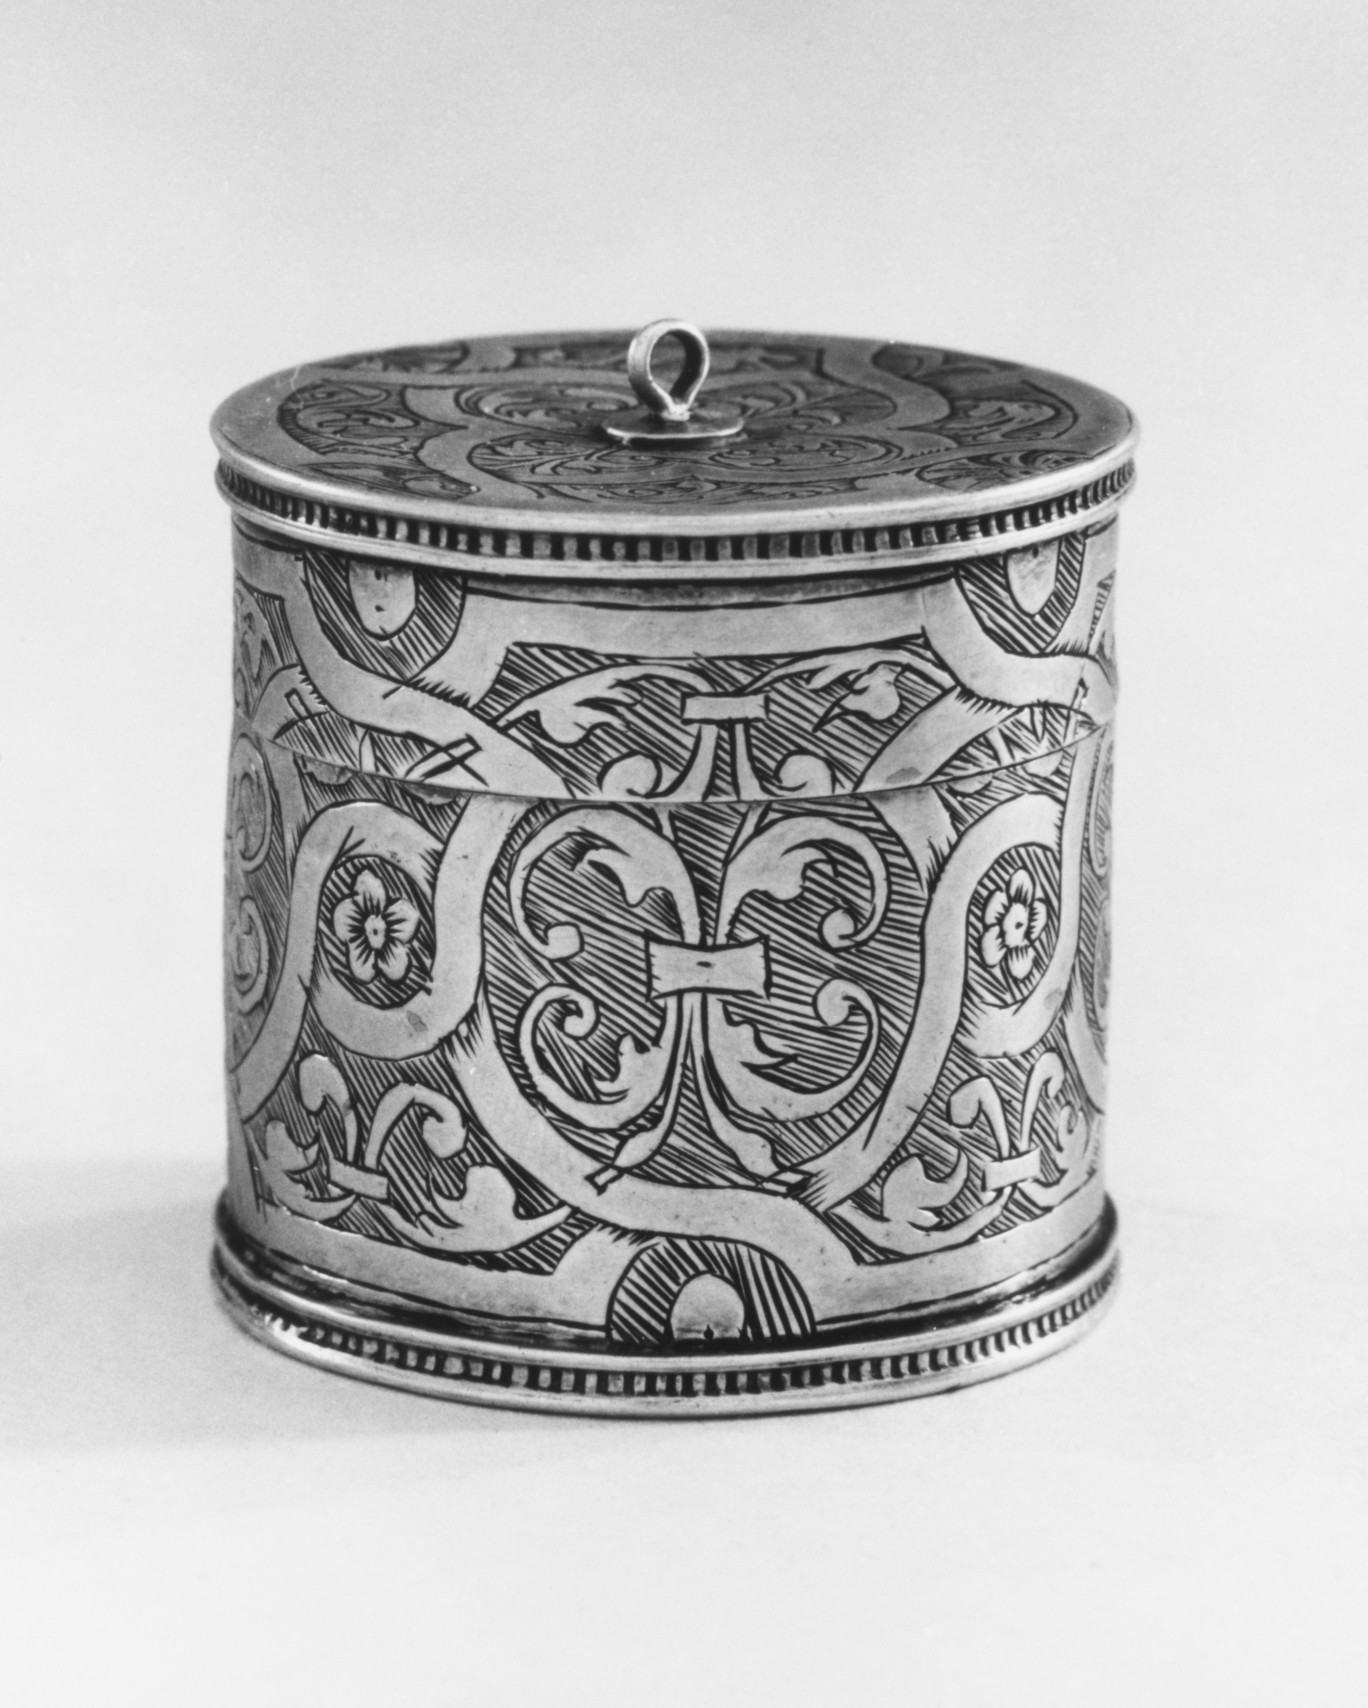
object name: salve pot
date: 1576-1600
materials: silver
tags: flowers